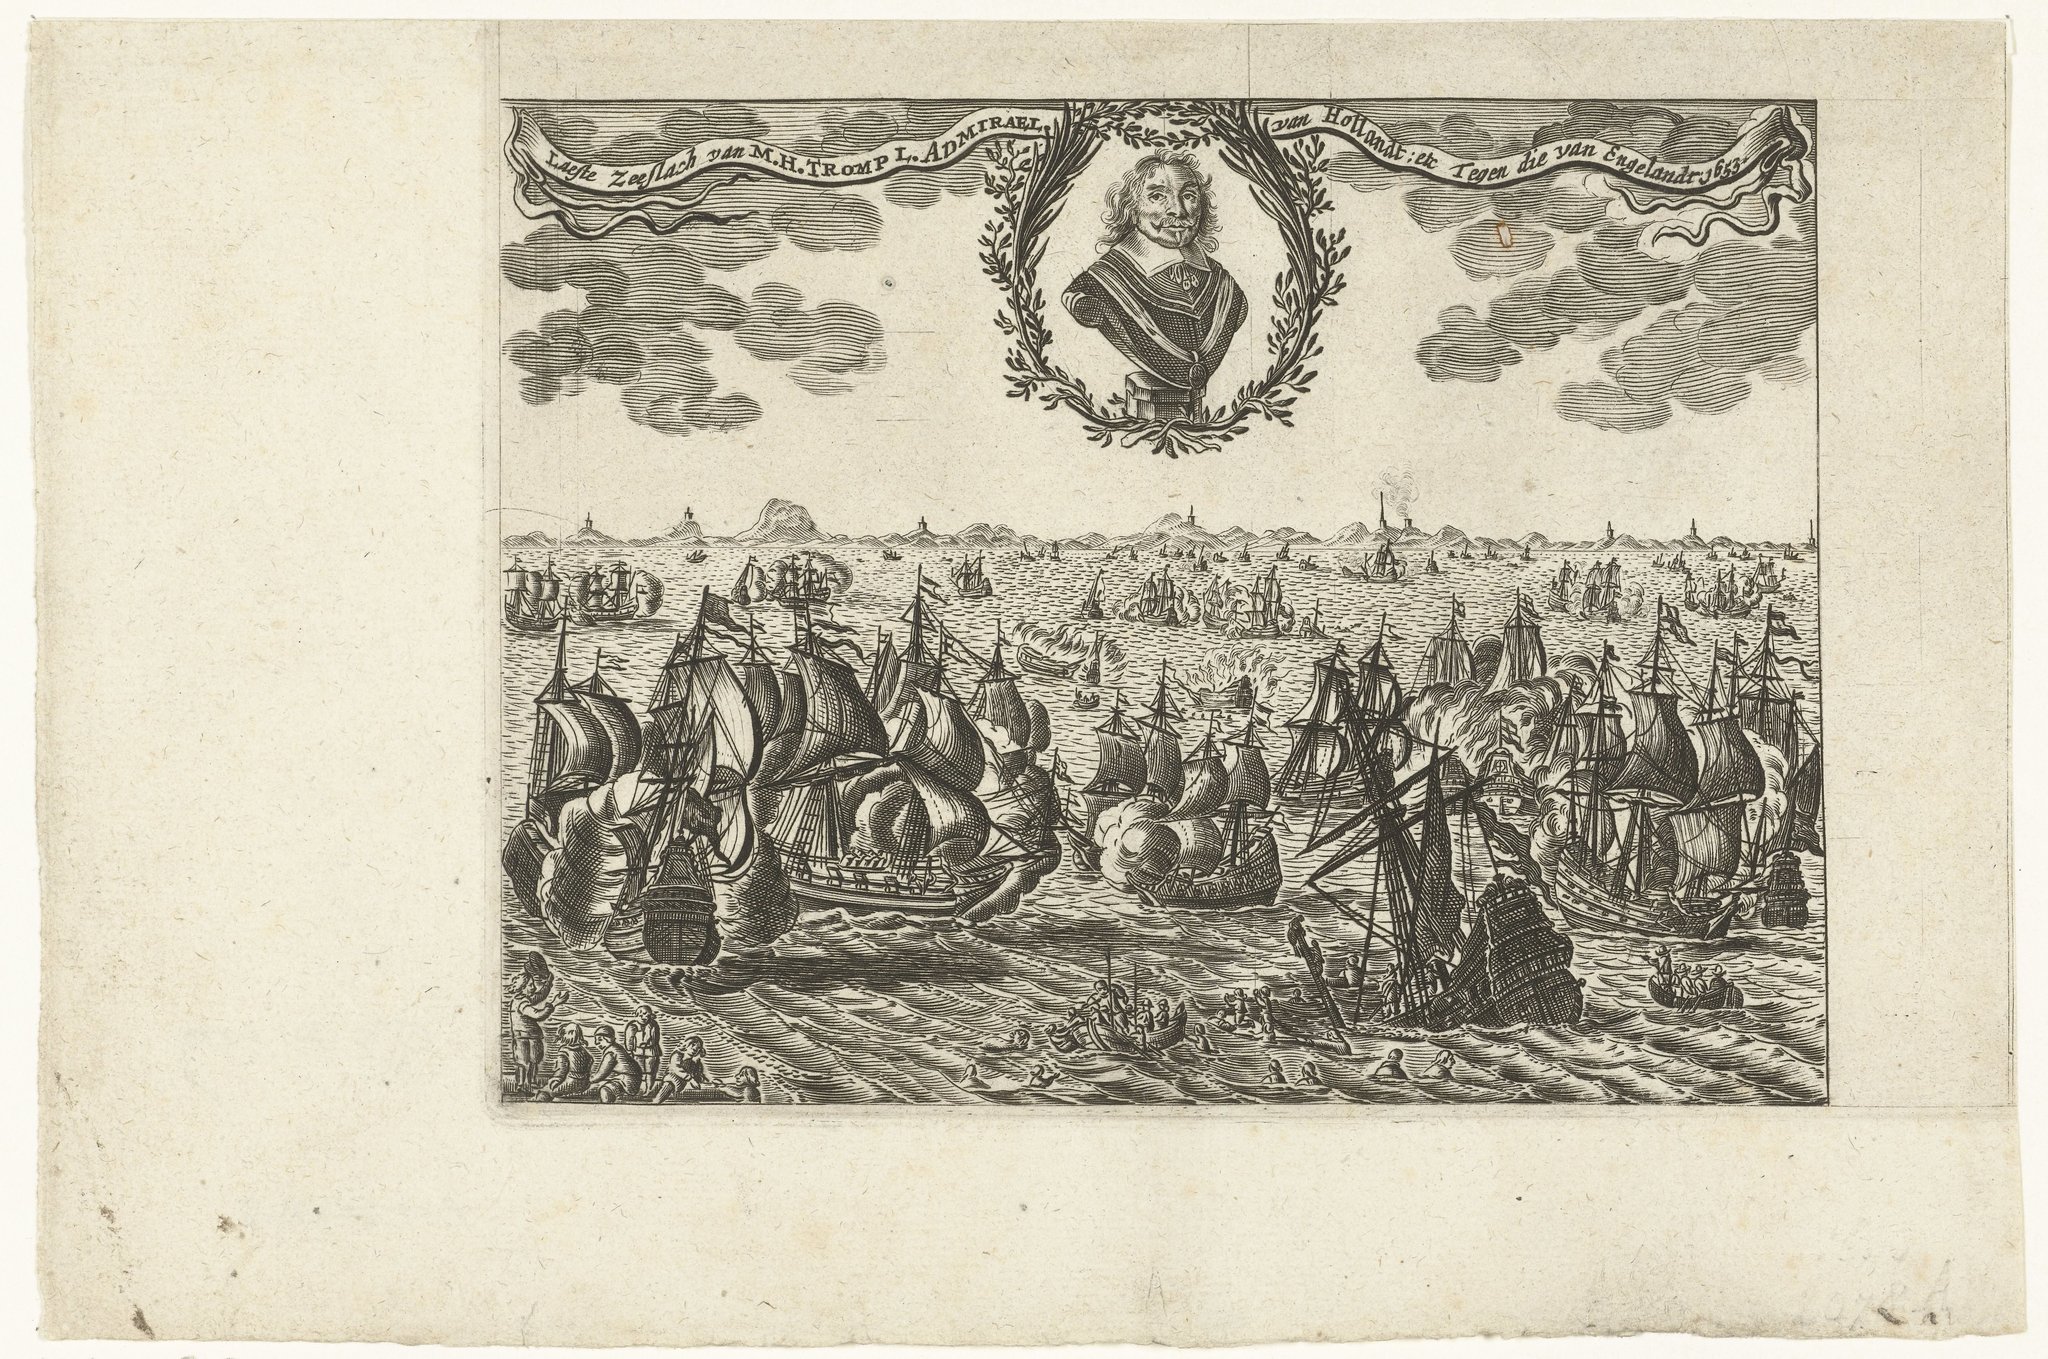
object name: print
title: Laeste zeeslach van M.H. Tromp L. Admirael van Hollandt; etc. Tegen die van Engelant 1653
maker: Anonymous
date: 1653-1699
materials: paper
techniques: engraving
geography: northern netherlands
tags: brielle, maarten harpertszoon tromp, battle (+ naval force), battle of scheveningen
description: De zeeslag bij Terheide in de Eerste Engelse Oorlog tussen de Staatse vloot onder Maarten Tromp en de Engelse vloot onder George Monck, 10 augustus 1653. Bovenaan een portret van M.H. Tromp in lauwerkrans. Maarten Tromp sneuvelde tijdens dit gevecht. In het verschiet de Hollandse kust.